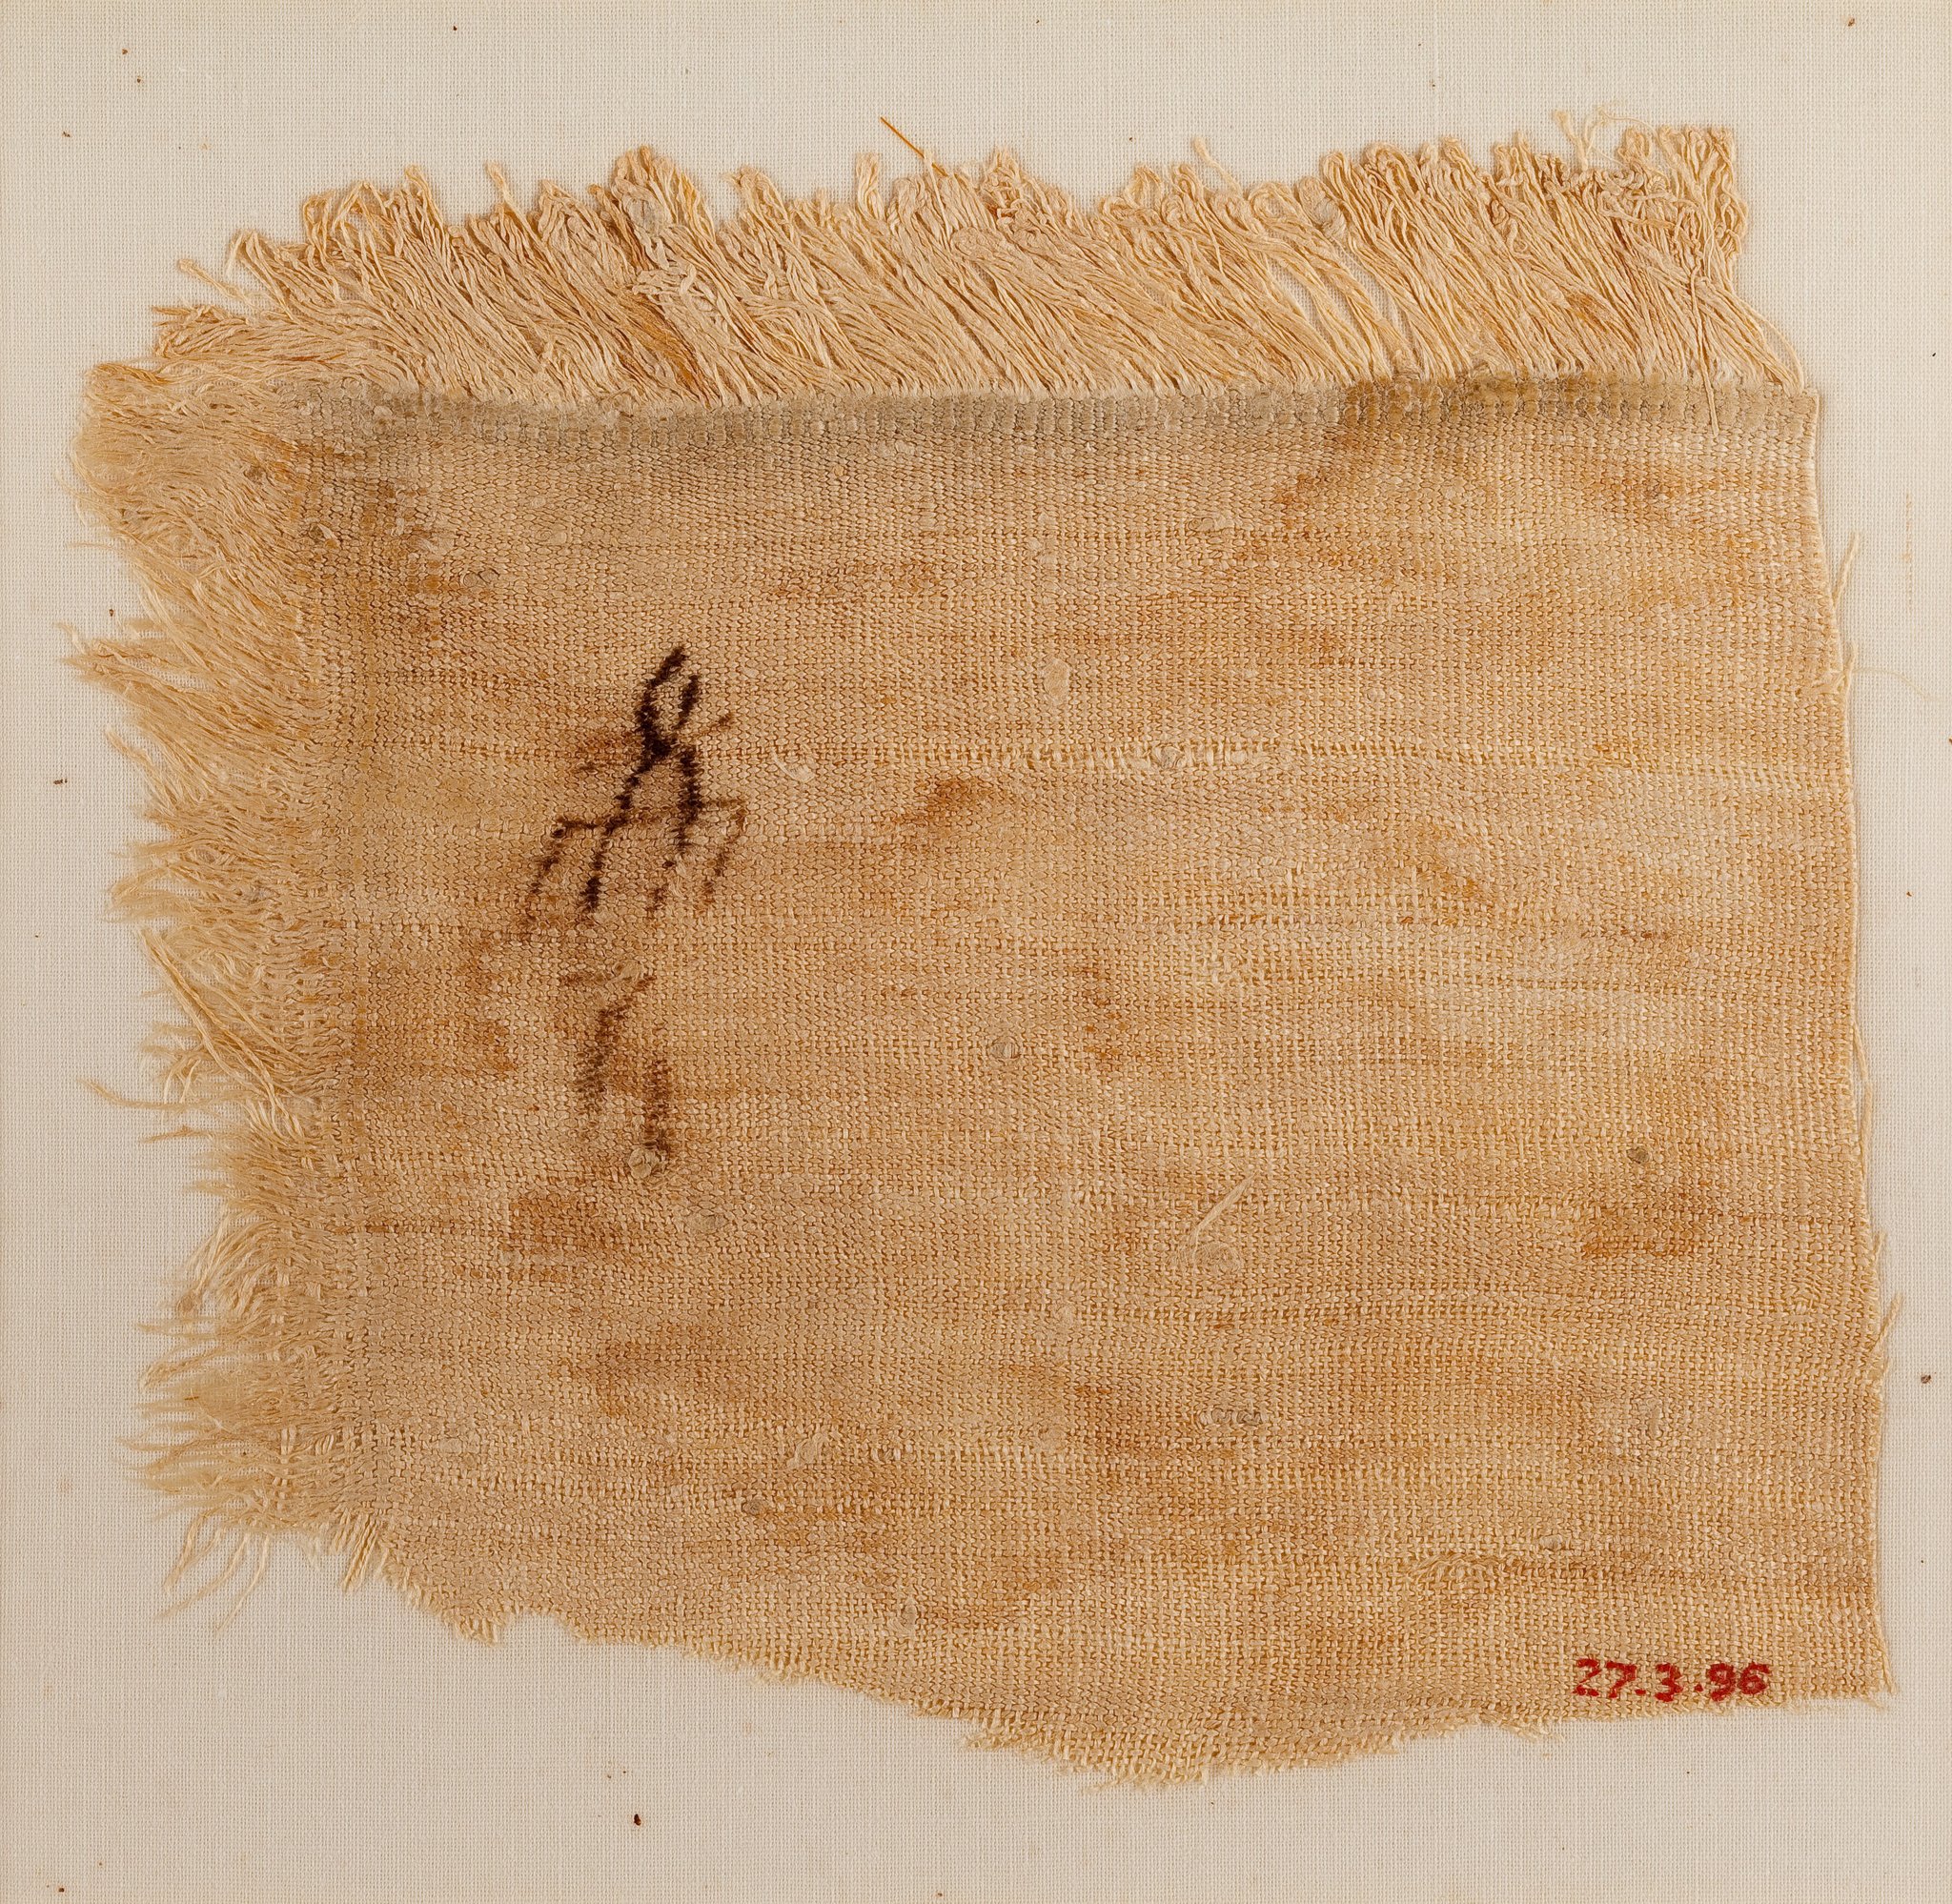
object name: linen mark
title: Linen mark (Type IV)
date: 1961-1917 BCE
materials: linen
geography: egypt